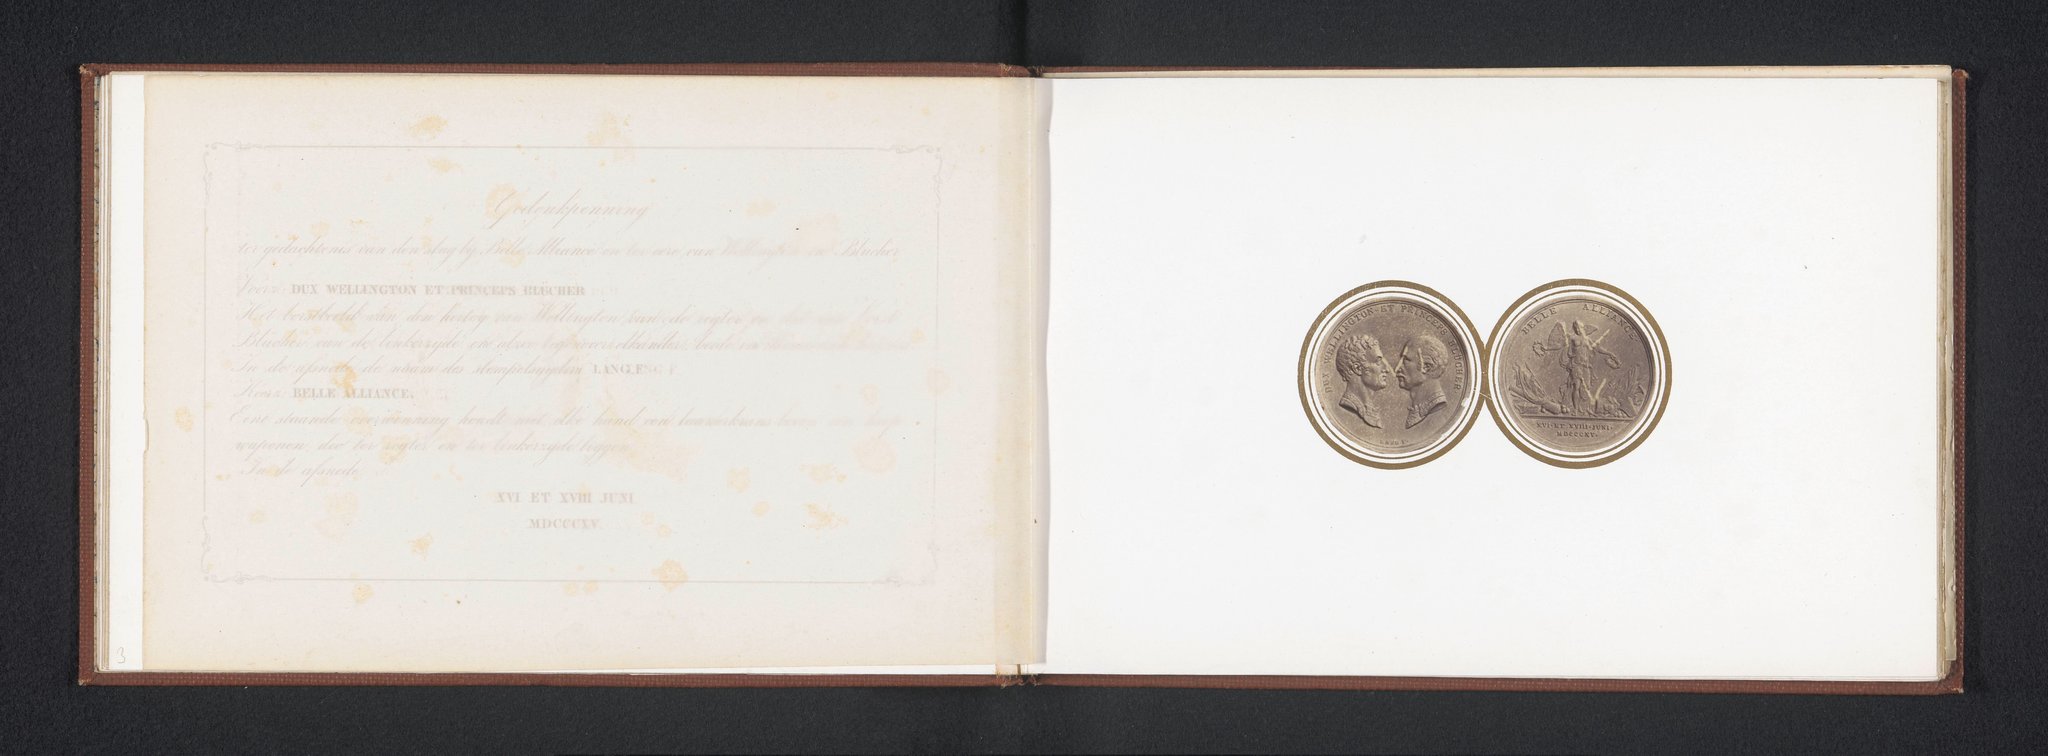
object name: page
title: Twee afbeeldingen van een gedenkpenning ter nagedachtenis aan de Slag bij Waterloo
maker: willem matla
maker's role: fotograaf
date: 1865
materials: paper, photographic support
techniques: albumen print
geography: the hague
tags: memorial medal, victory, adult man (+ sideview, profile)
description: Links de voorzijde met twee bustes van de Duke of Wellington en Gebhard von Blücher, rechts de keerzijde met de Overwinning.